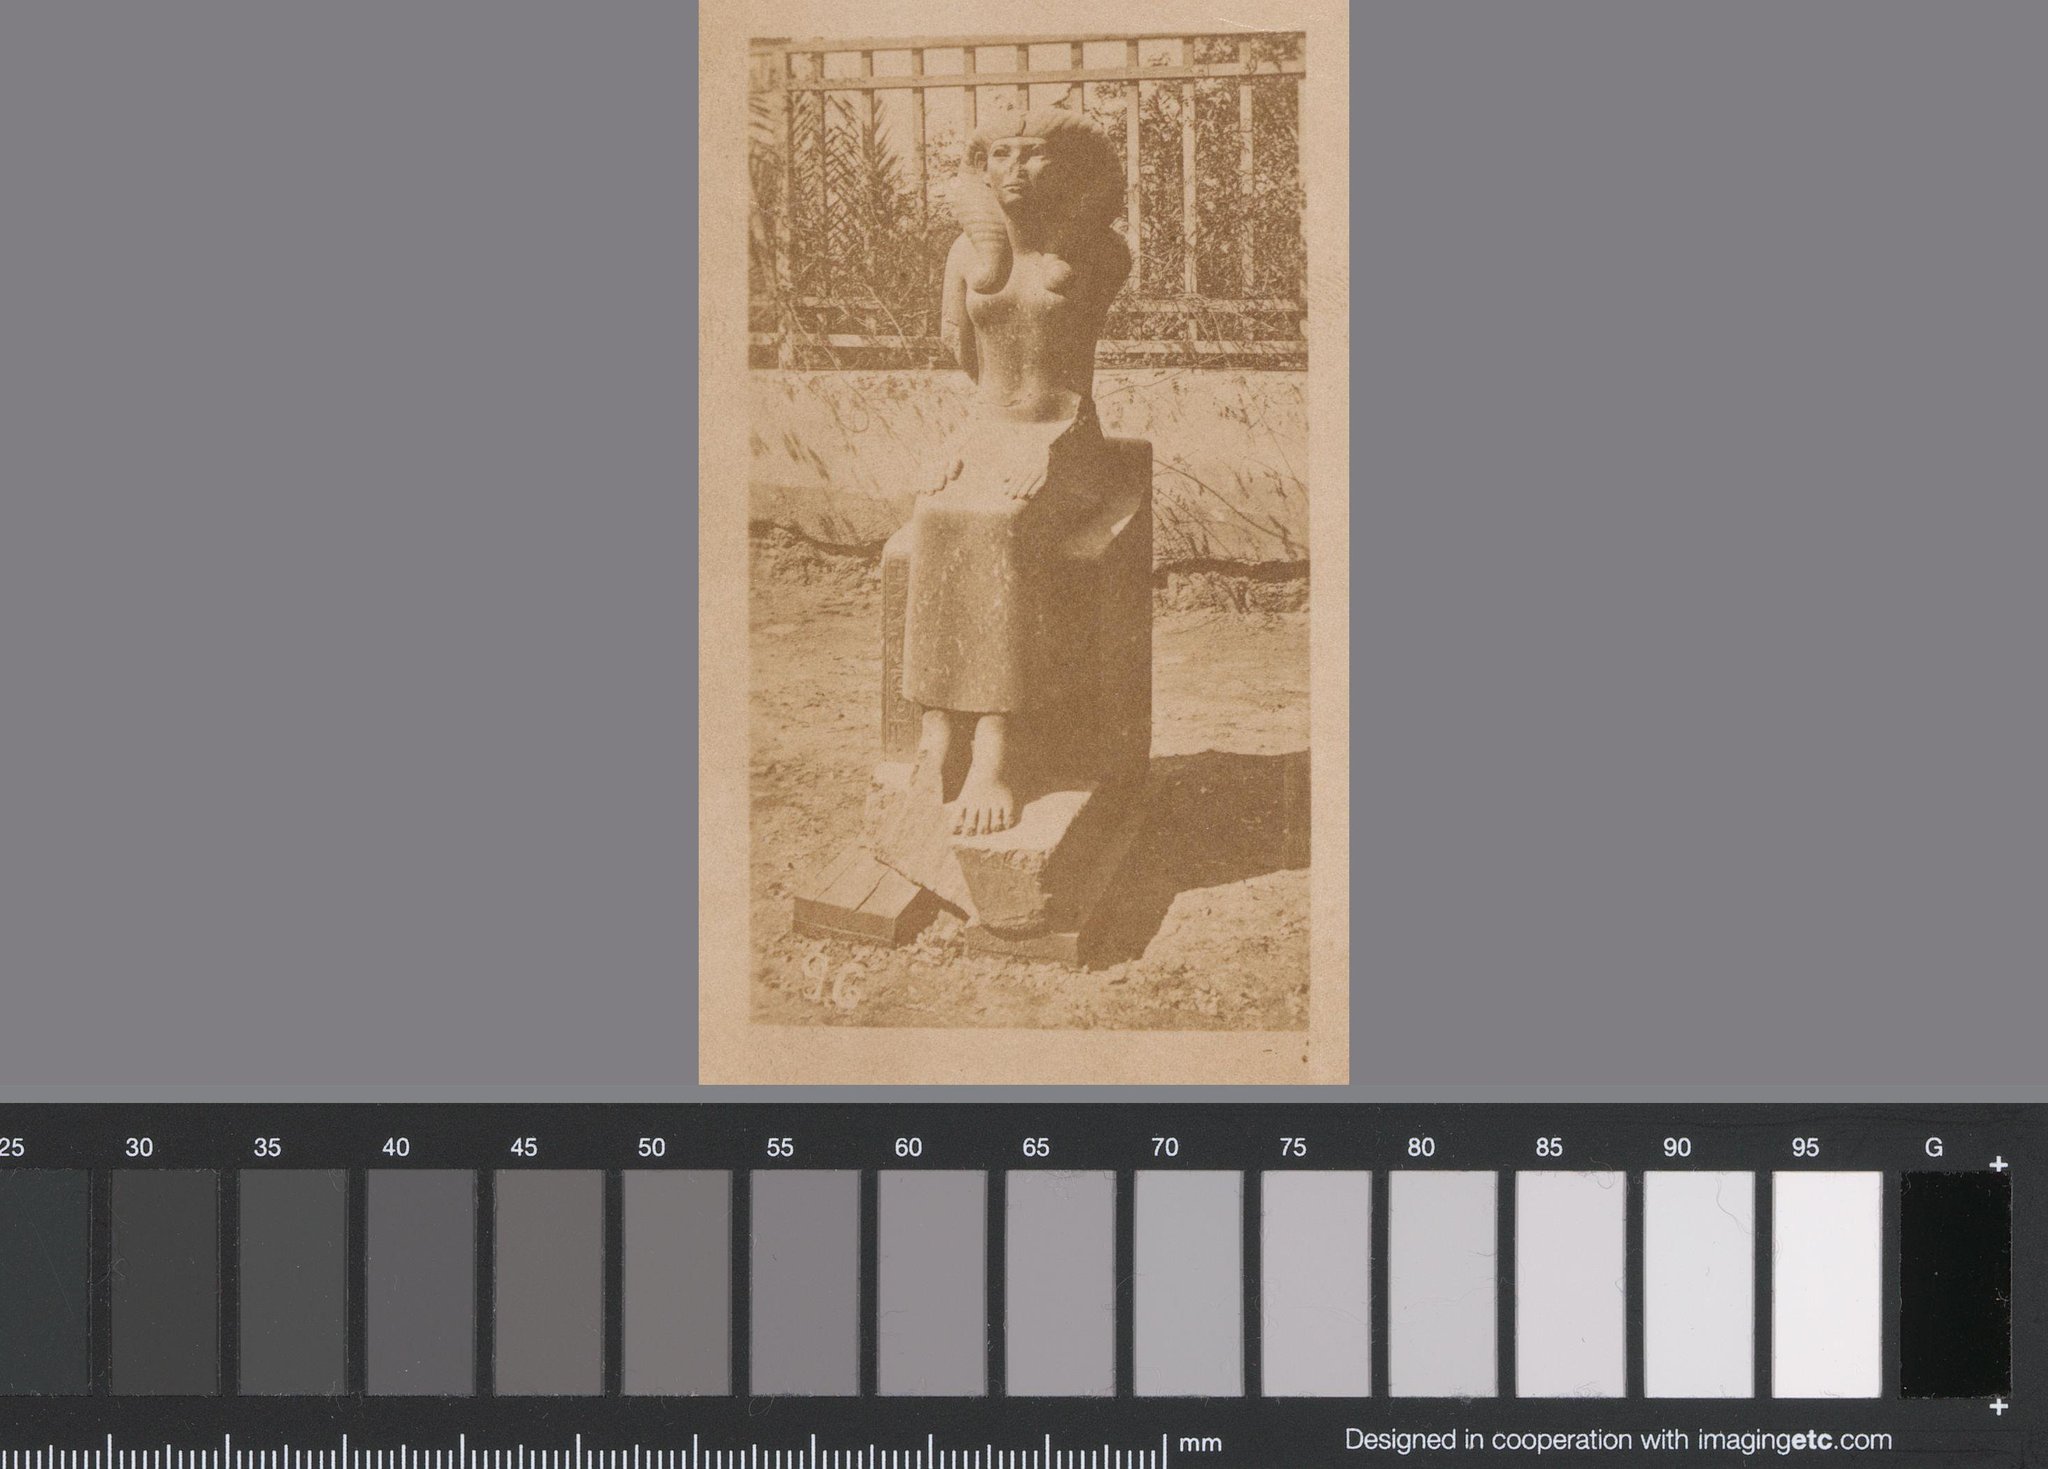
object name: photograph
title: Egyptische sculptuur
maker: Anonymous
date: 1870-1890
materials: photographic support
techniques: albumen print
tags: piece of sculpture, reproduction of a piece of sculpture